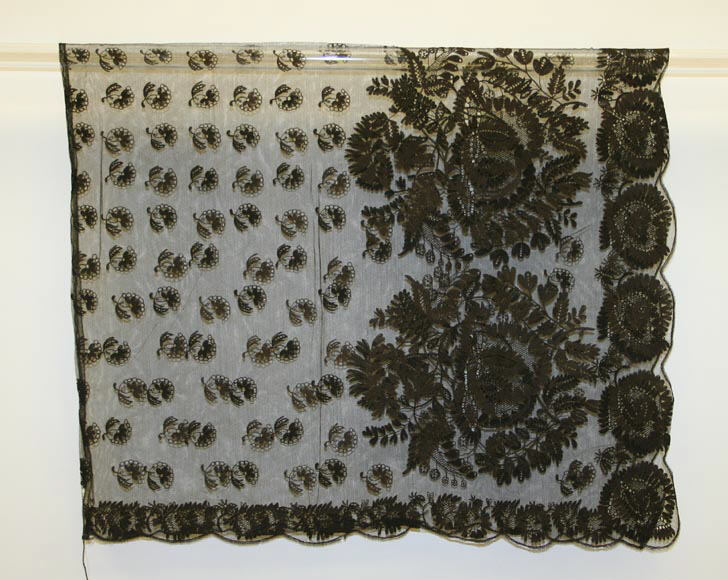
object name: veil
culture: american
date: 1830-1839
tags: flowers